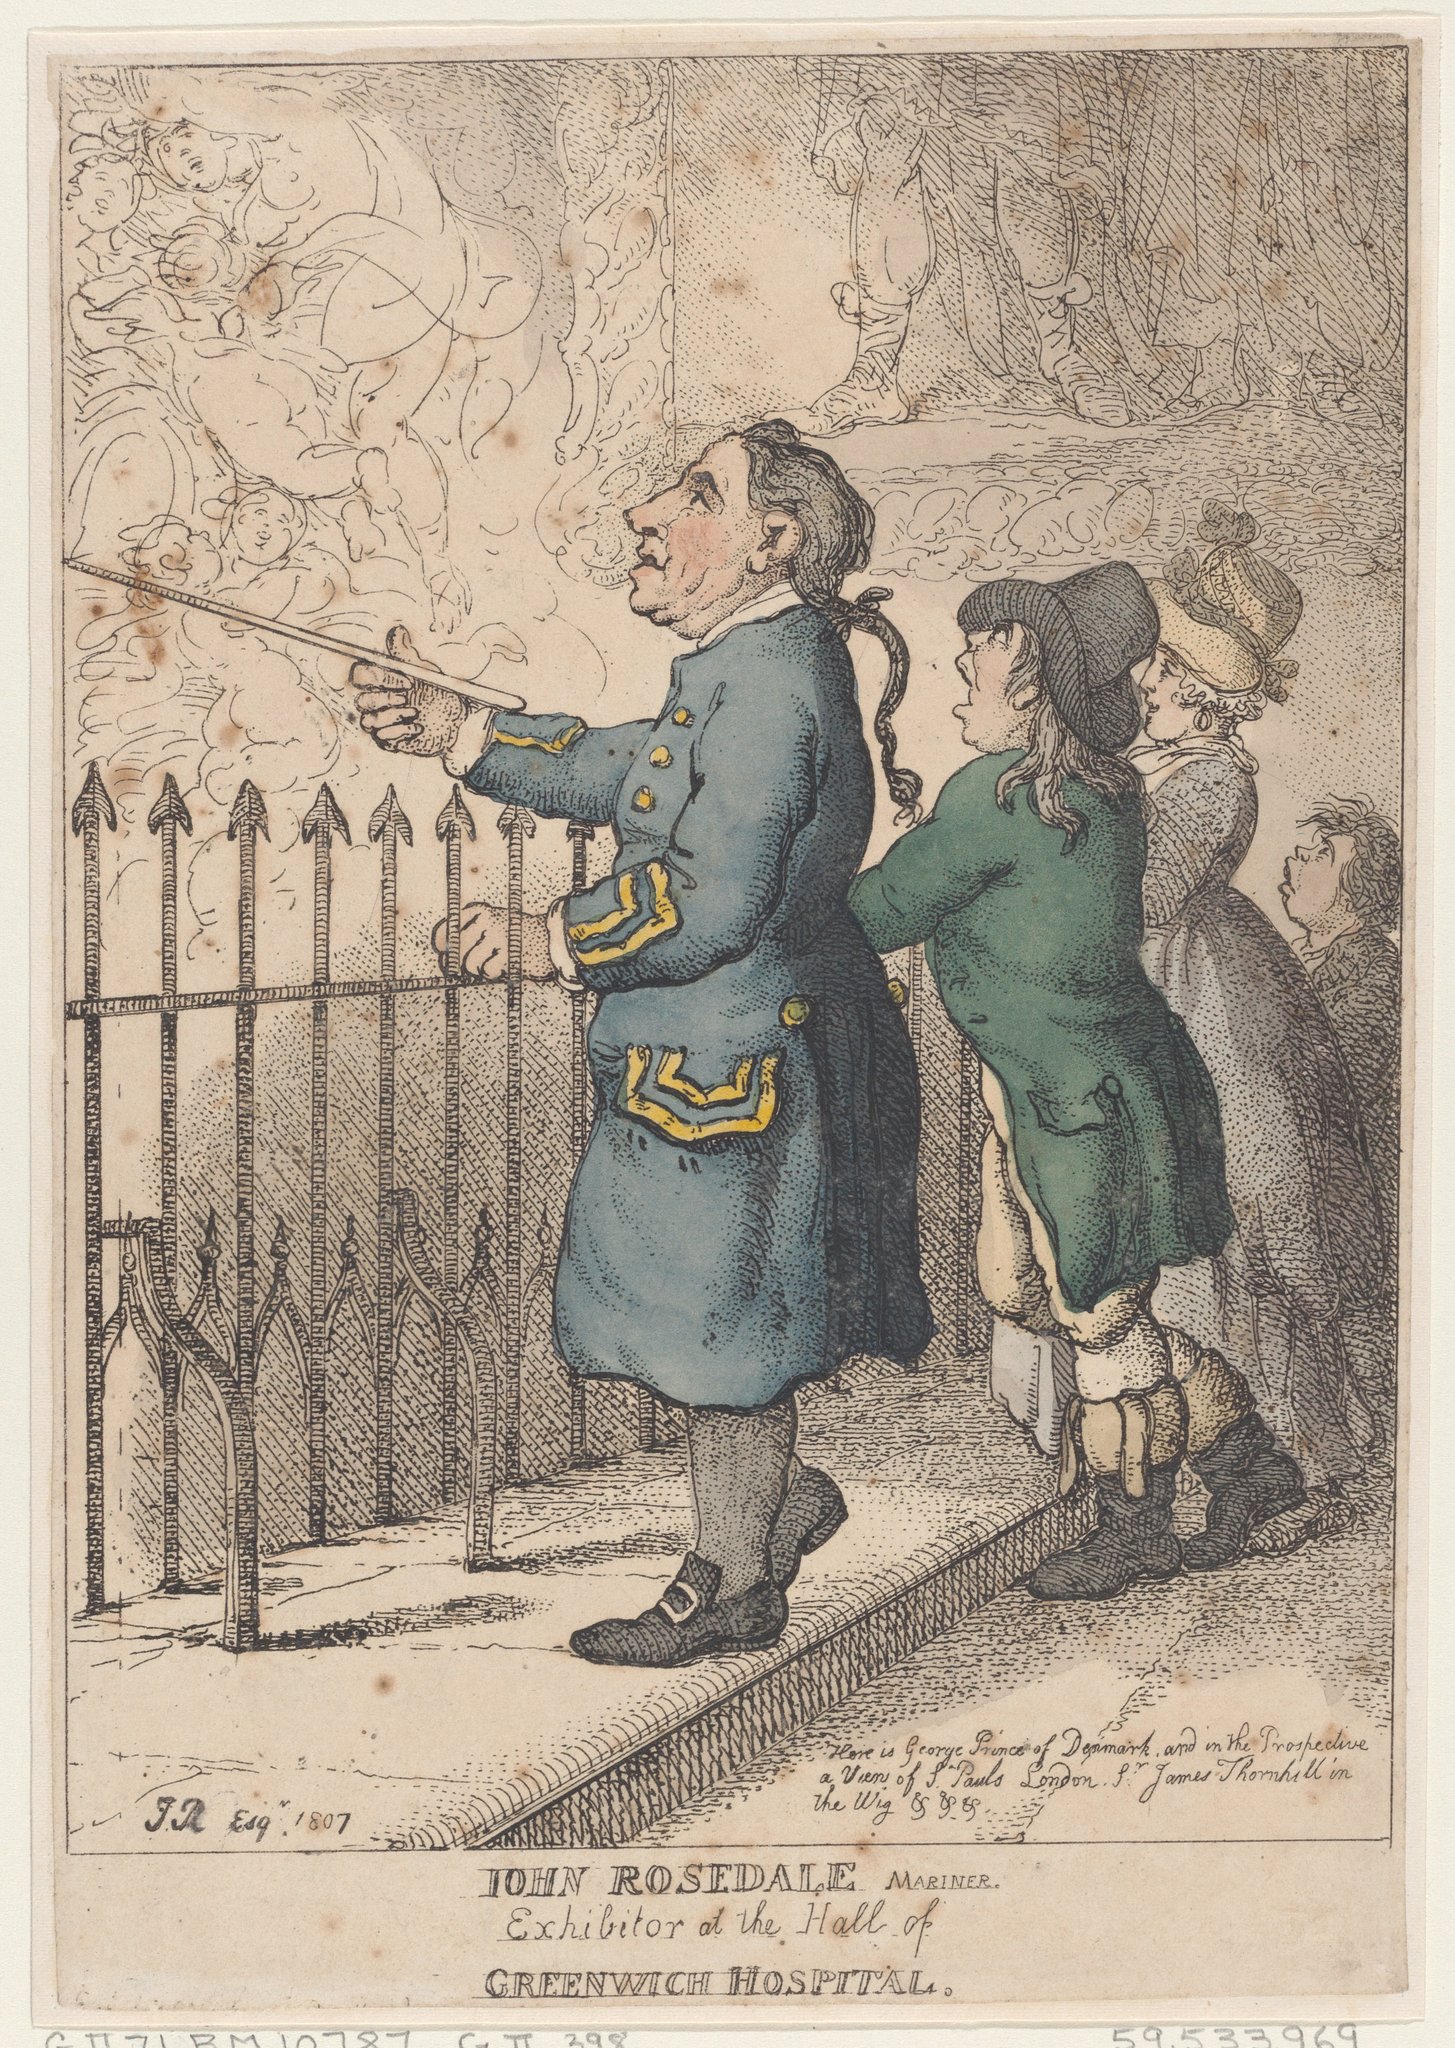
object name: print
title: John Rosedale Mariner, Exhibitor at the Hall of Greenwich Hospital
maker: thomas rowlandson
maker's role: artist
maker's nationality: british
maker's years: 1757-1827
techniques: etching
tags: satire,men,women